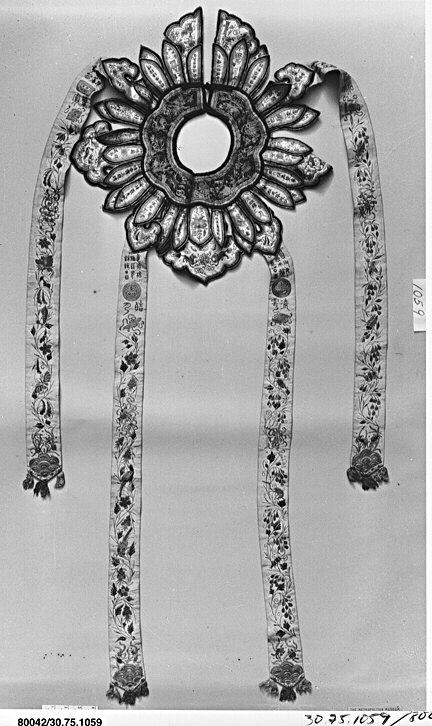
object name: collar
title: Collar with Various Symbols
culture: chinese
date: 1701-1900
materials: gold, silk